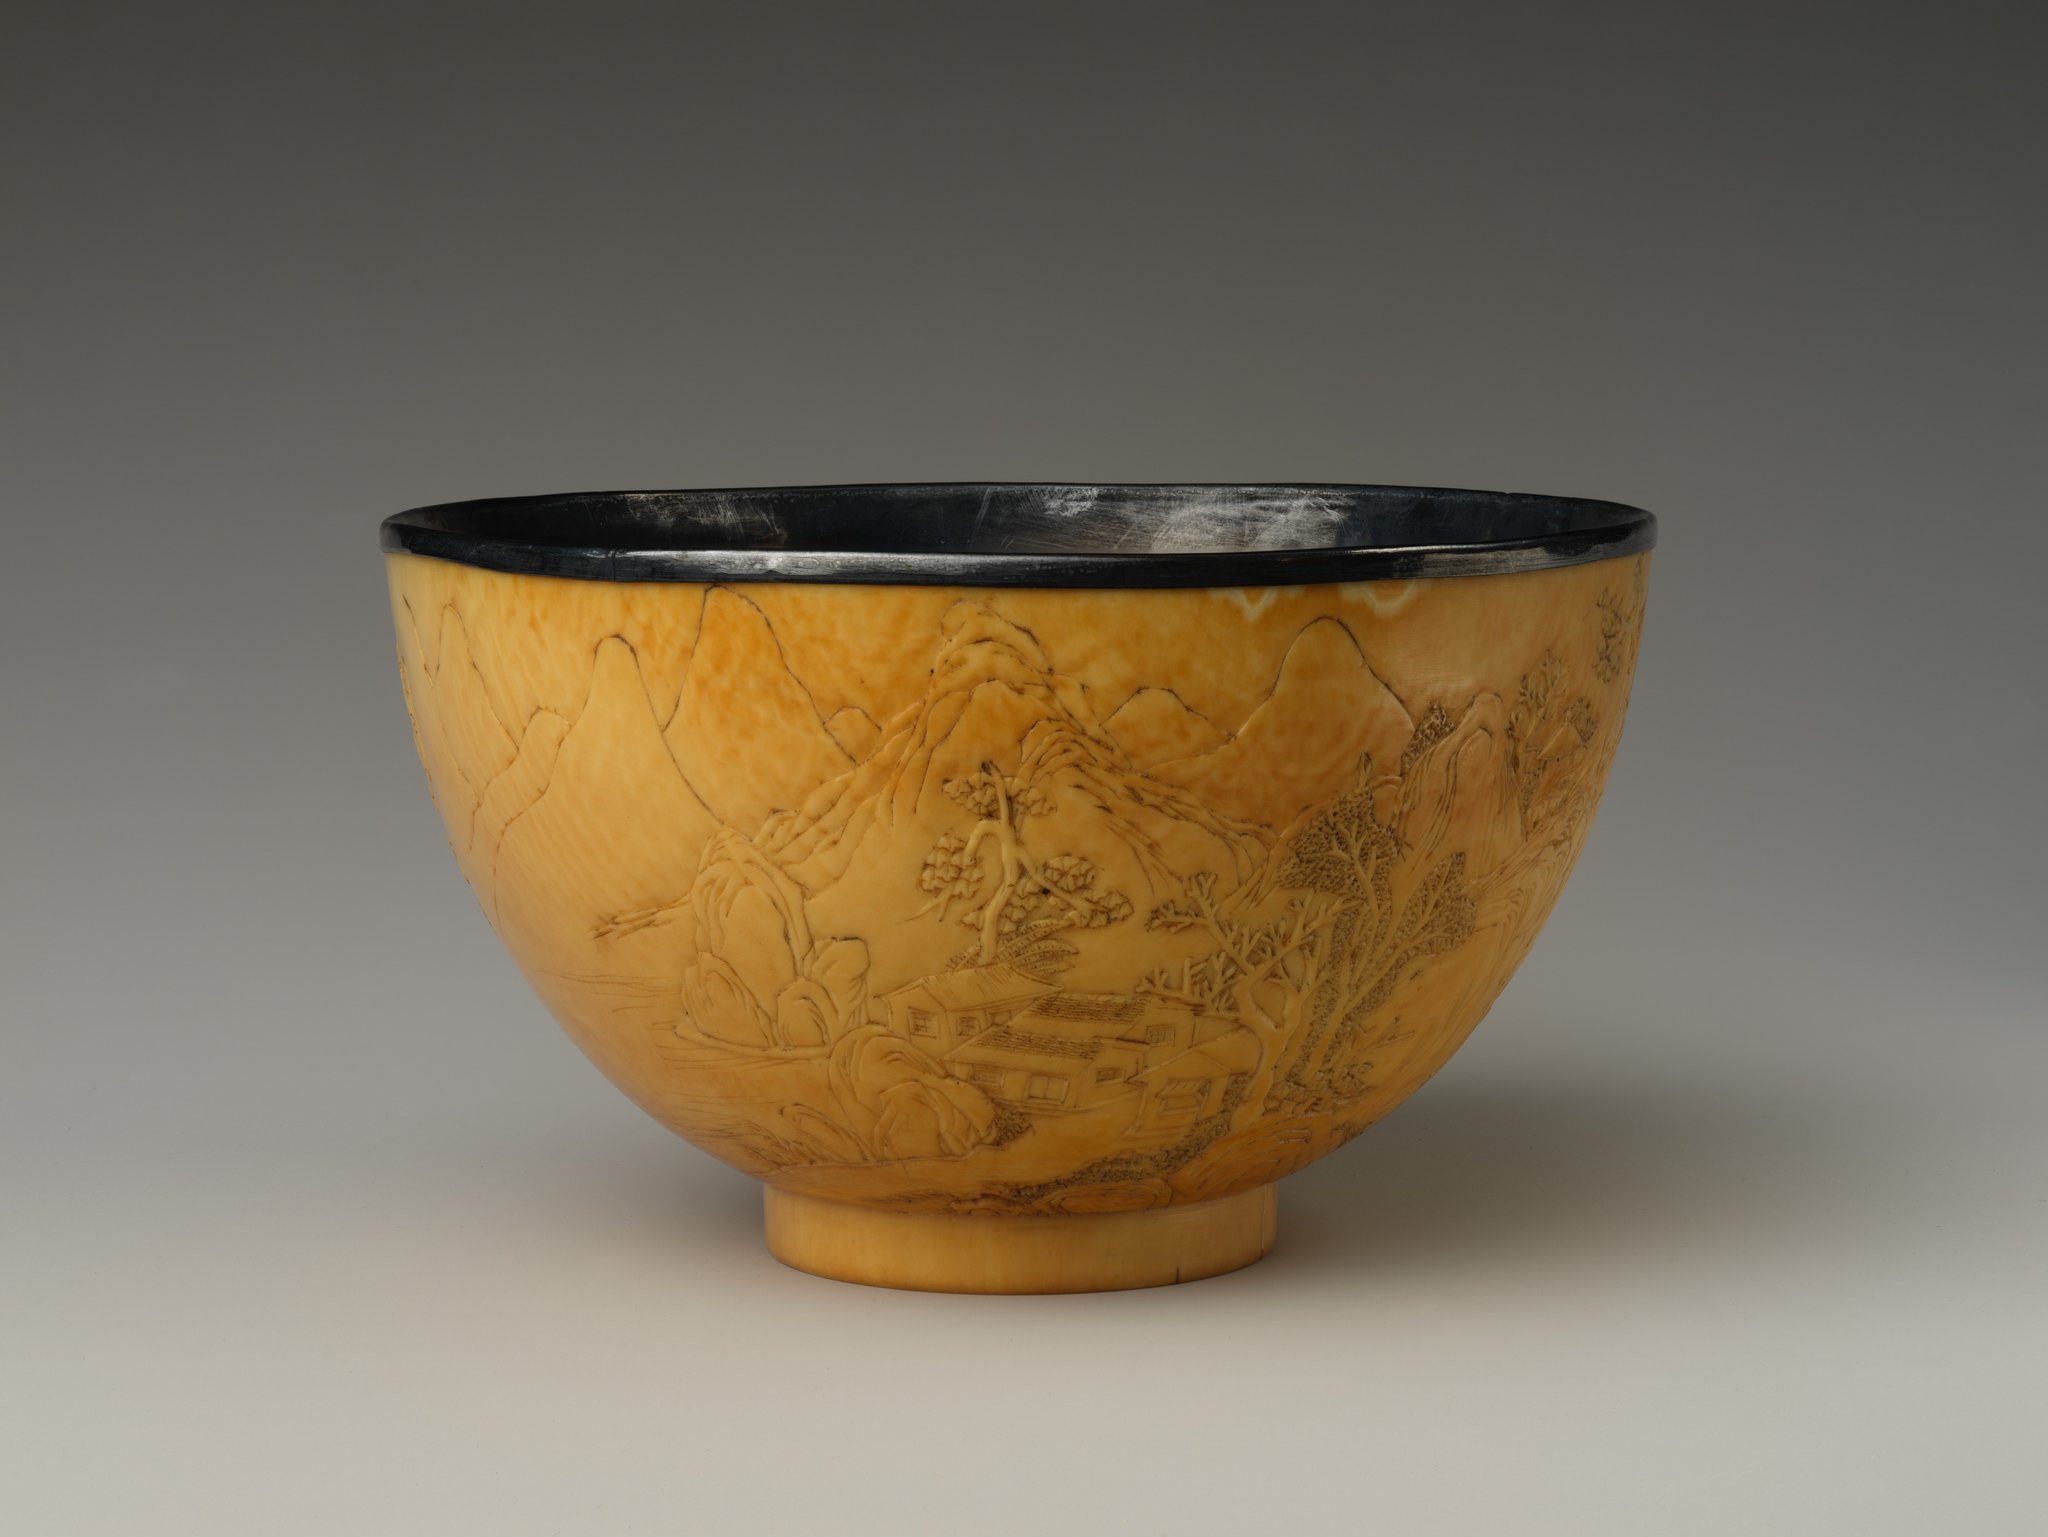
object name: bowl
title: Bowl with carved inscription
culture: chinese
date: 1743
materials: ivory, silver